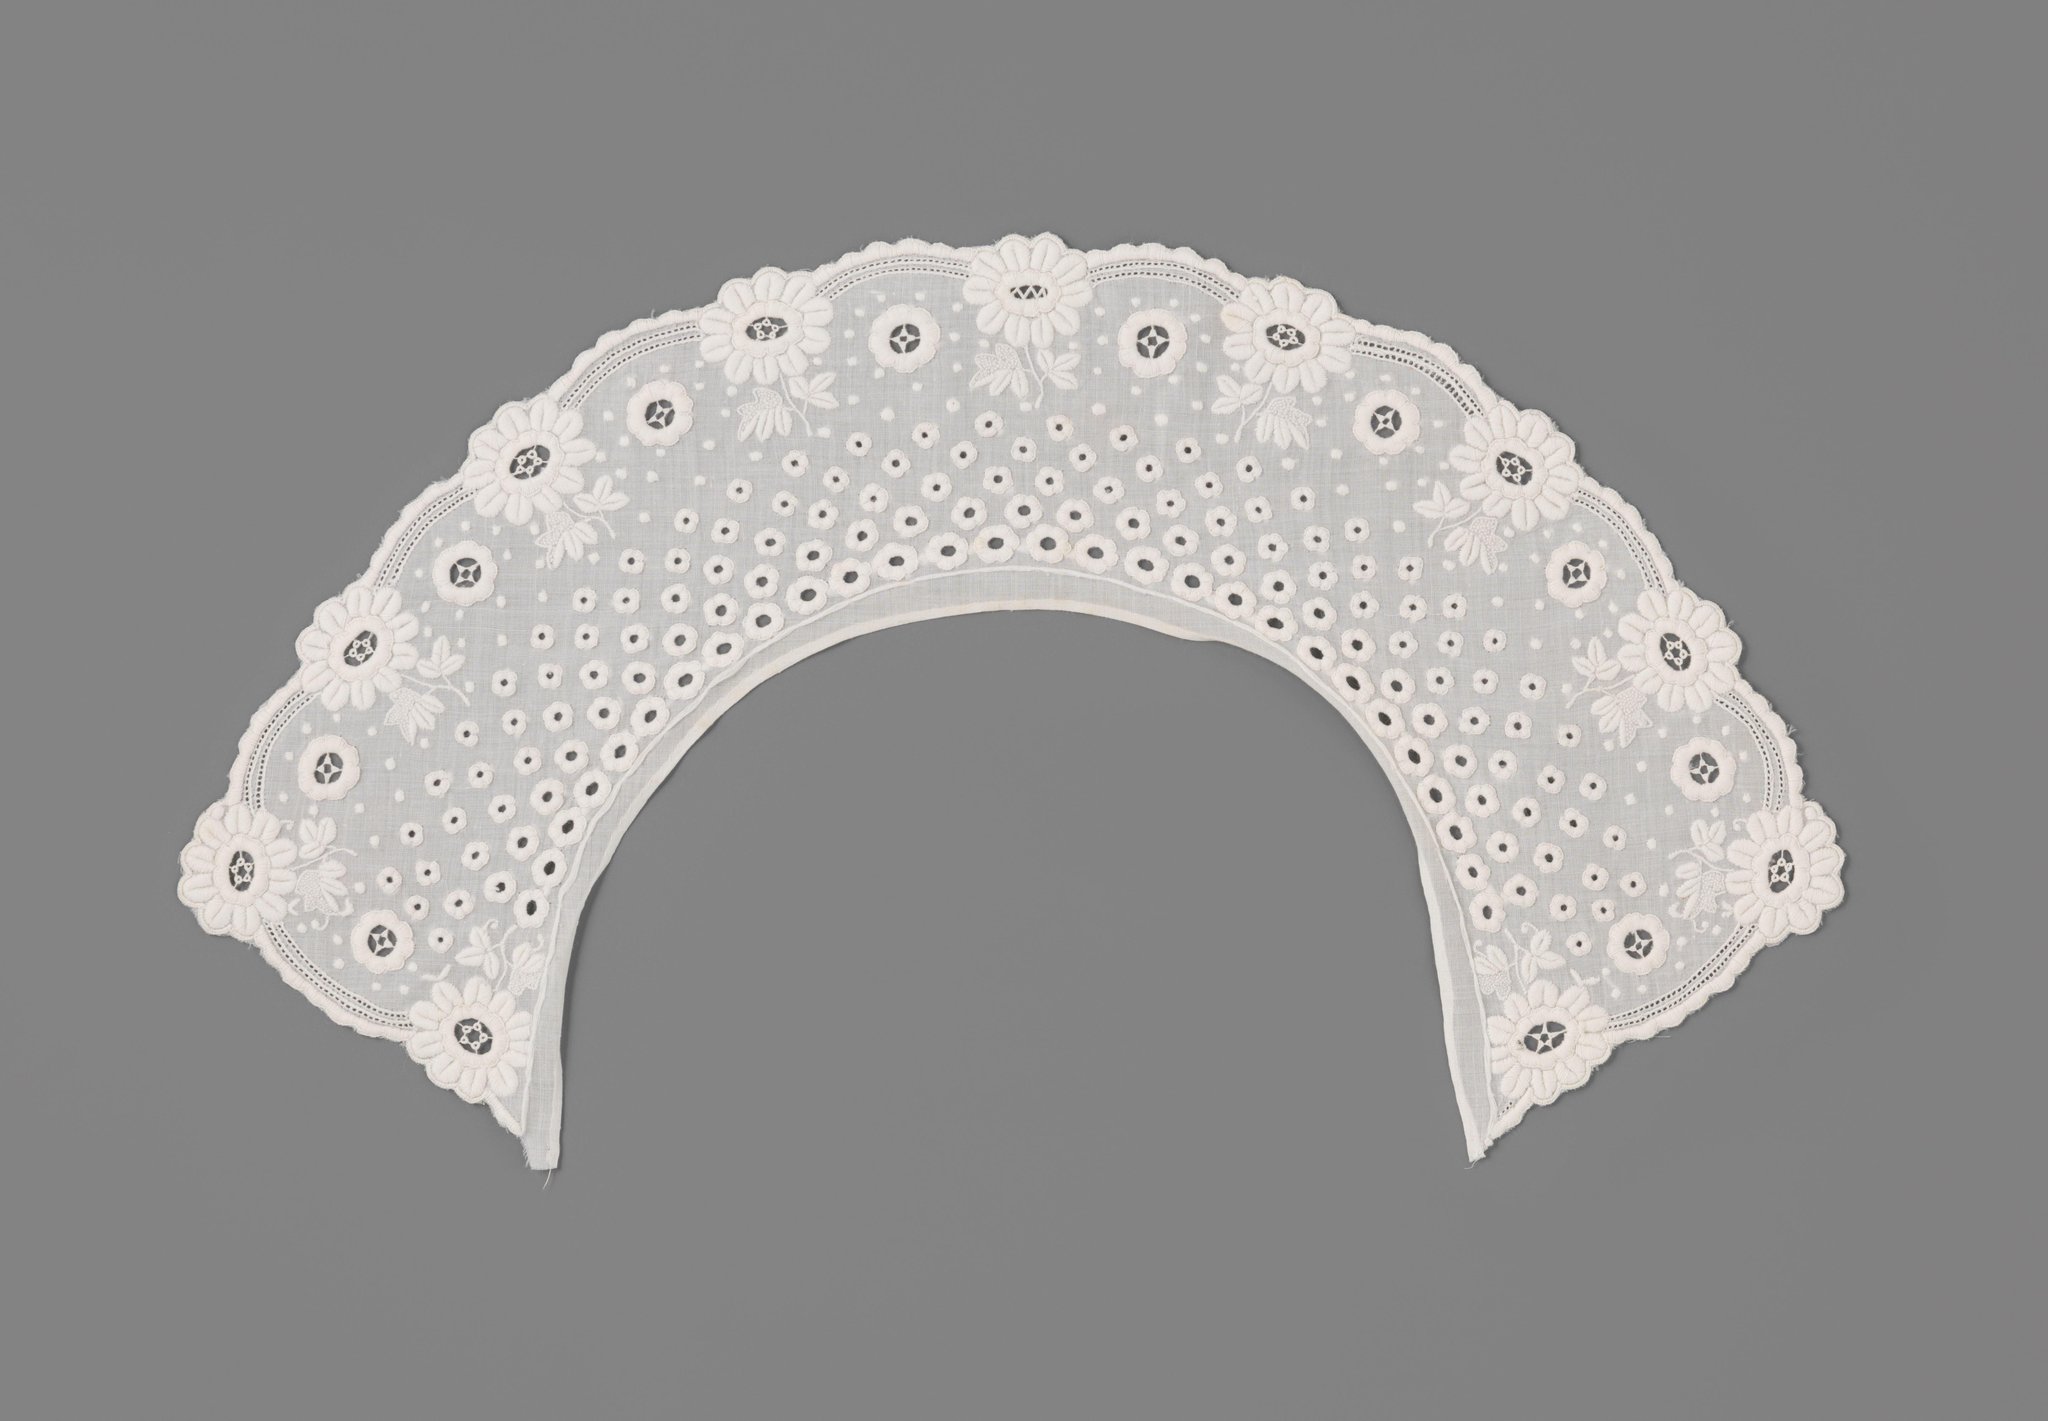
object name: womenswear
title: Kraag van batist die is versierd met witwerk in de vorm van rozen en moesjes en is afgezet met een schulprand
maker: Anonymous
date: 1850-1860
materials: linen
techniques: embroidery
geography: switzerland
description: Kraag van linnenbatist die is afgezet met een schulprand. De kraag is versierd met witwerk in de vorm moesjes en bloemen. Op de knooppunten van de schulpen zijn rozen geborduurd.